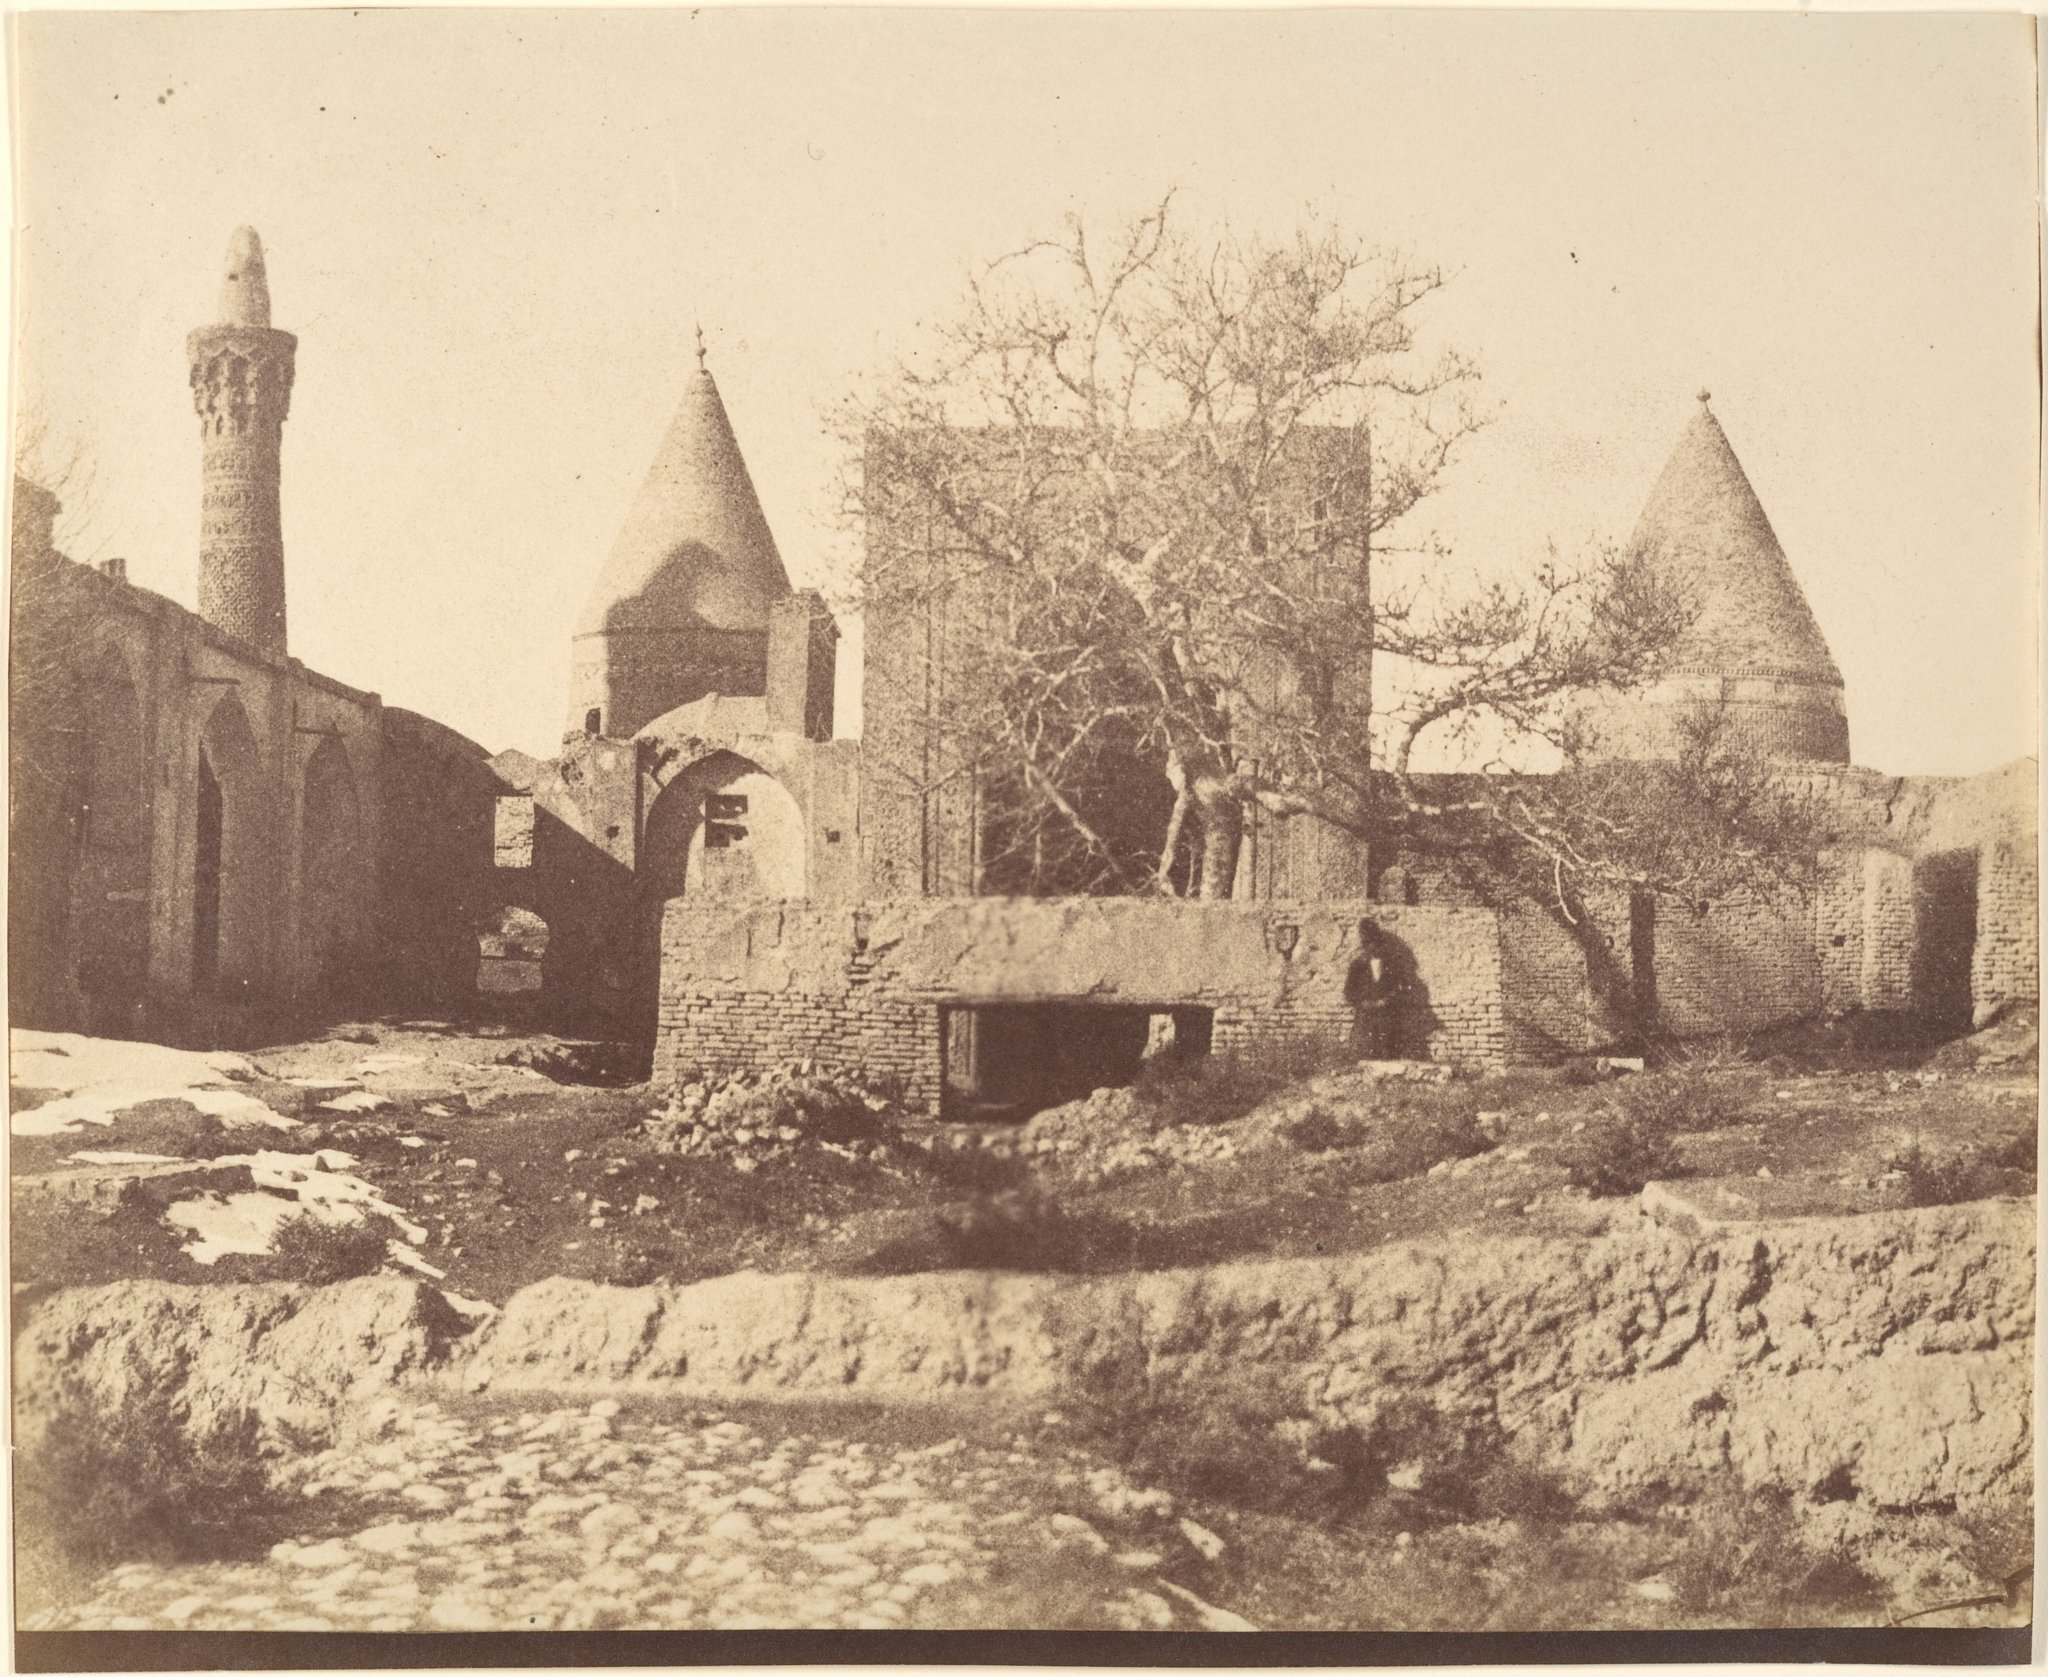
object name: photograph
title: [Tomb of Bayazid, BISTAM]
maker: luigi pesce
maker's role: artist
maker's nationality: italian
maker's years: 1818-1891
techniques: albumen silver print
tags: architecture,tombs